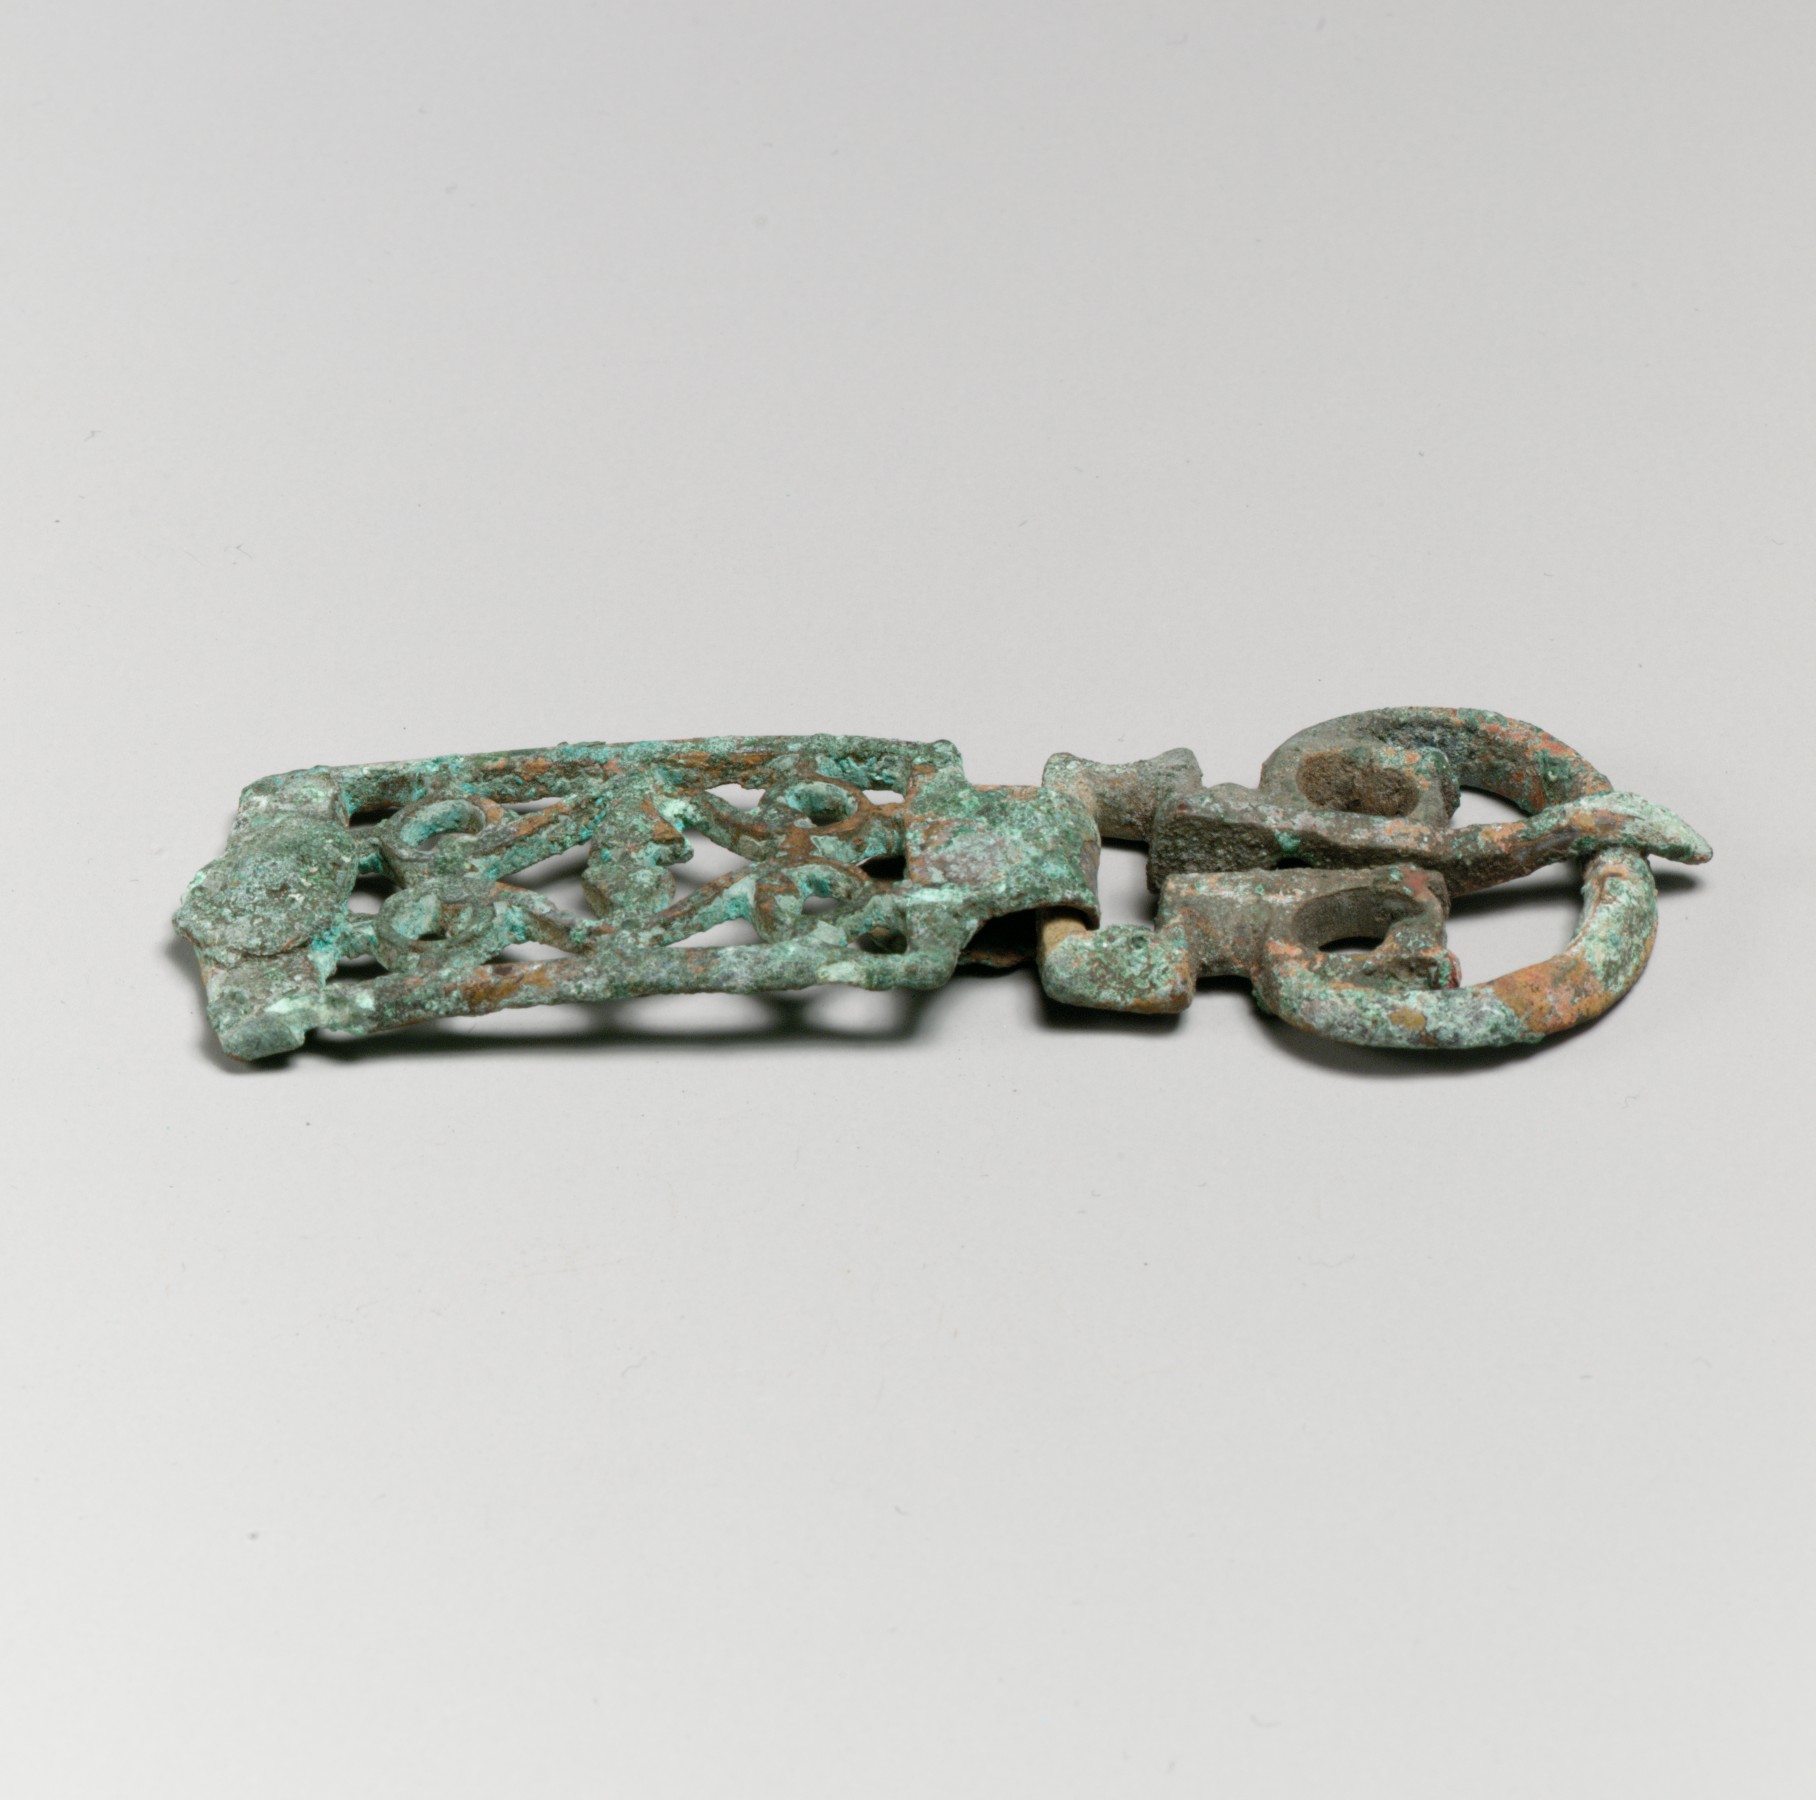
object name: buckle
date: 7000 BCE-330 CE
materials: bronze